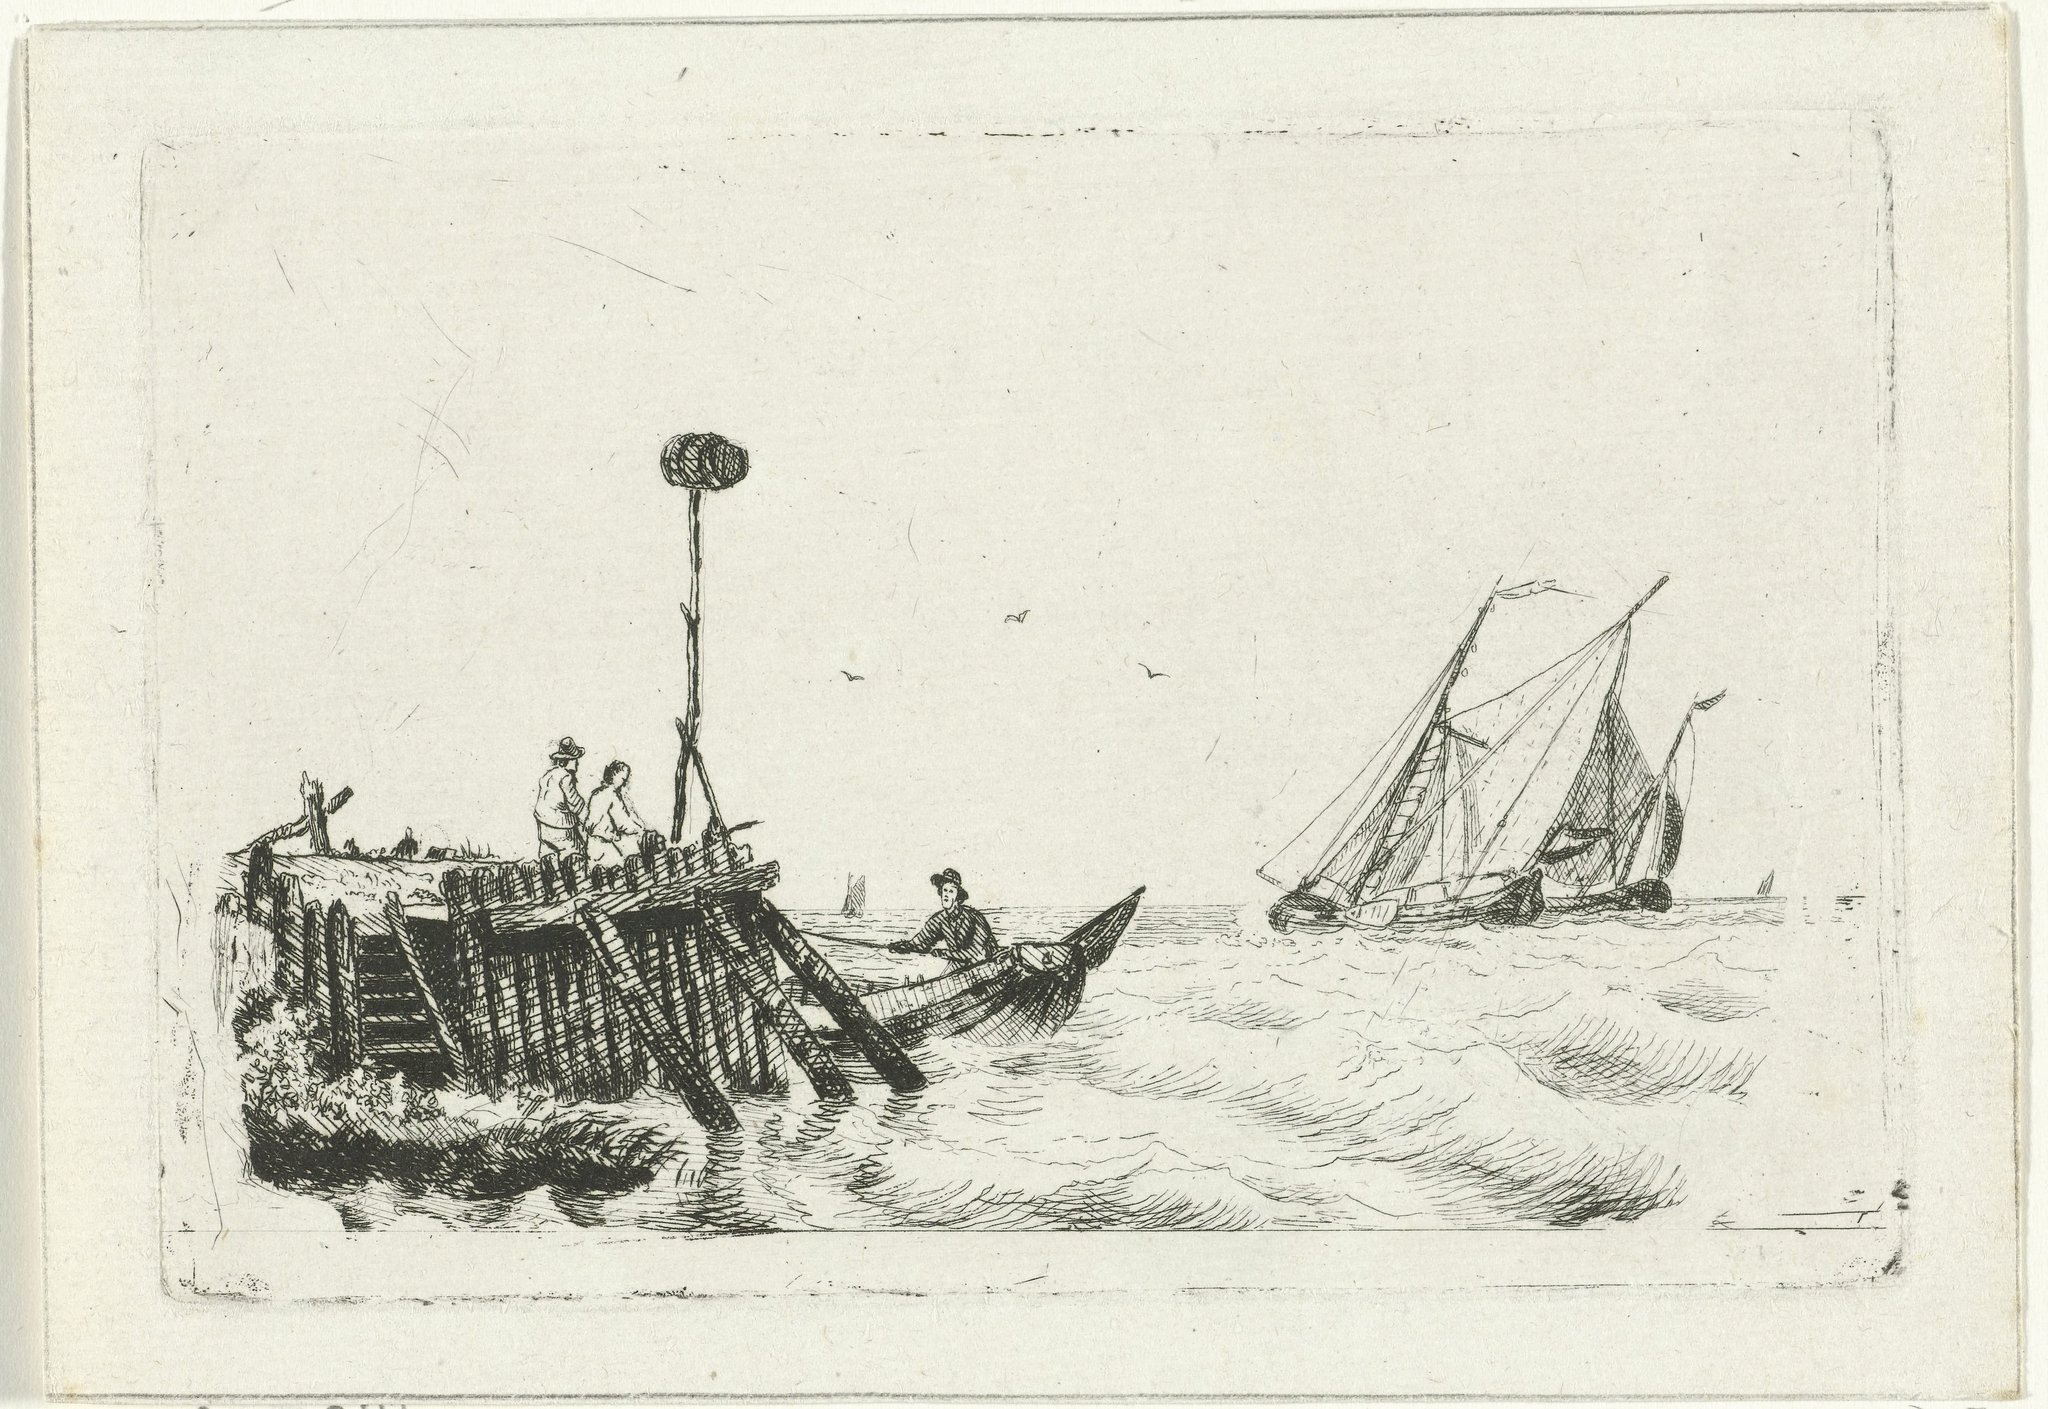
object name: print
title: Pier aan water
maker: willem gruyter jr.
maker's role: draughtsman, print maker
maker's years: 1817-1880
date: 1832-1880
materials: paper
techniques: etching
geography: amsterdam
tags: pier, quay, wharf (+ view ~ vehicle, ship, etc.)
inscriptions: collector's mark: Lugt 2165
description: Links een pier, waarachter een man in een roeiboot. Rechts op de achtergrond twee zeilschepen.